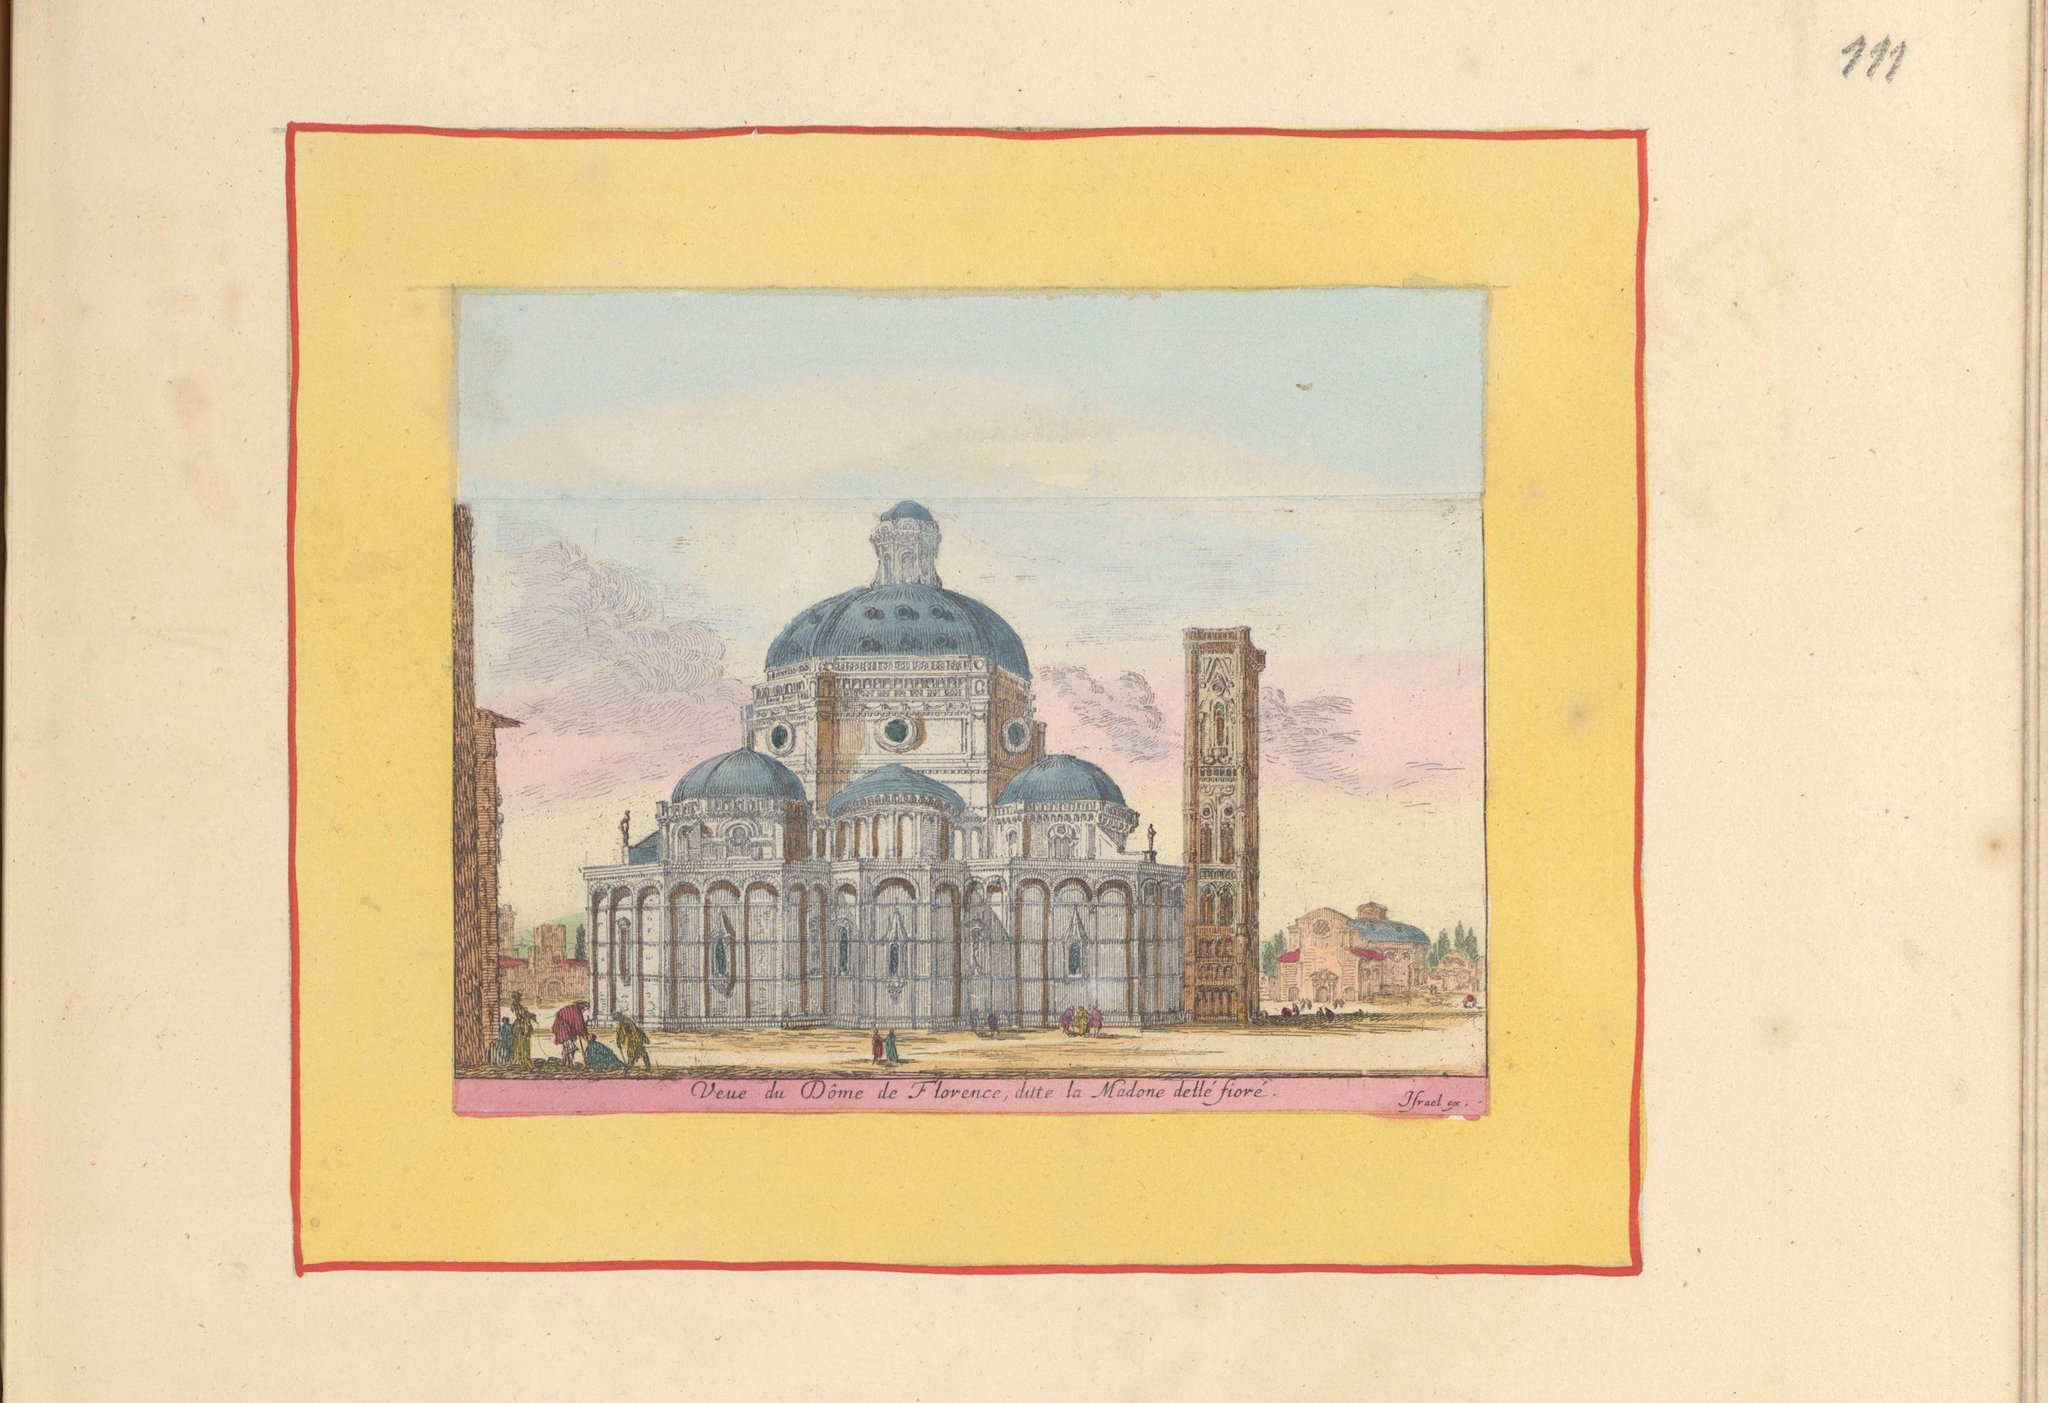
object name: album leaf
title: Gezichten op Italiaanse steden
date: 1631-1691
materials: paper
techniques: colour, etching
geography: paris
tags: parts of church exterior and annexes: campanile, city-view, and landscape with man-made constructions, church (exterior)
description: Gezicht op de achterzijde van de Dom van Florence. De Campanile staat aan de verkeerde zijde naast de kerk. Titel in het Frans in de ondermarge. Prent maakt deel uit van een album.